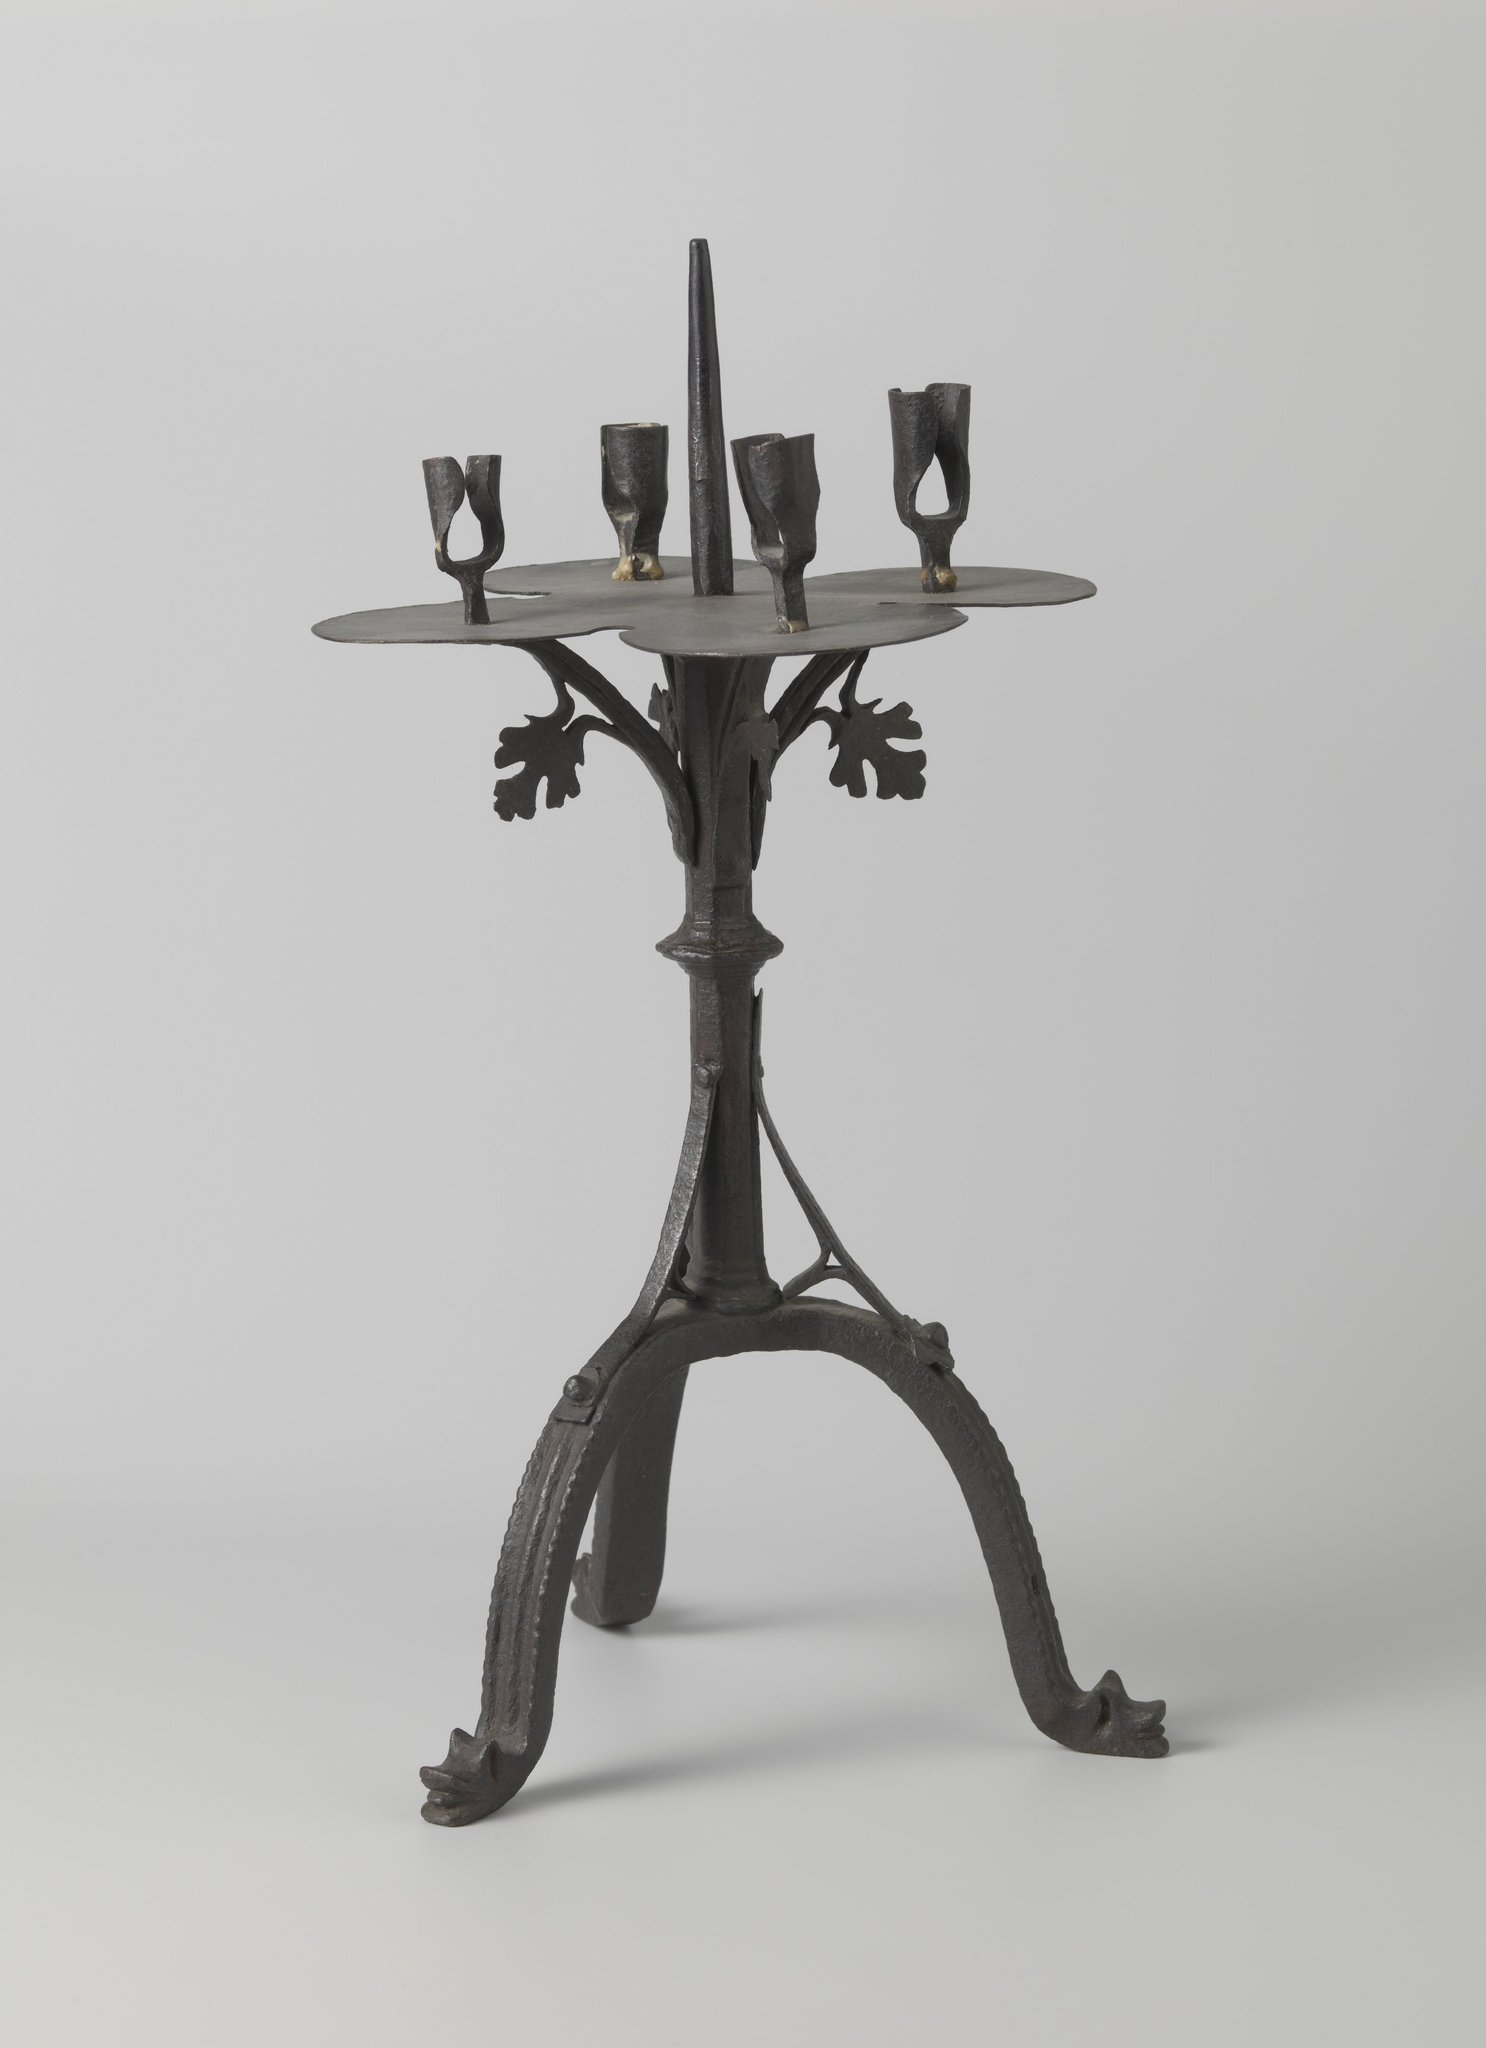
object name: candlestick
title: Kandelaar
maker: Anonymous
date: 1400-1600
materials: iron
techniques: forging, riveted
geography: western europe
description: Kandelaar van smeedijzer met een onderstel van drie poten, eindigend in een gestileerde drakenkop. Op het onderstel is de achthoekige stam met nodus geplaatst. Op de overgang van de drie poten naar de stam zijn drie platte versieringen geklonken. Aan de bovenzijde van de stam ontspringen drie armen met een enkele bladversiering. Daarboven is een vlakke, klaverbladvormige vetvanger geplaatst met daarin vijf gaten, waardoor respectievelijk de kaarsenpin en de vier kaarsenhouders steken. De kaarsenhouders zijn aan de armen van de stam geklonken. In een van de poten is een rond gat aangebracht.